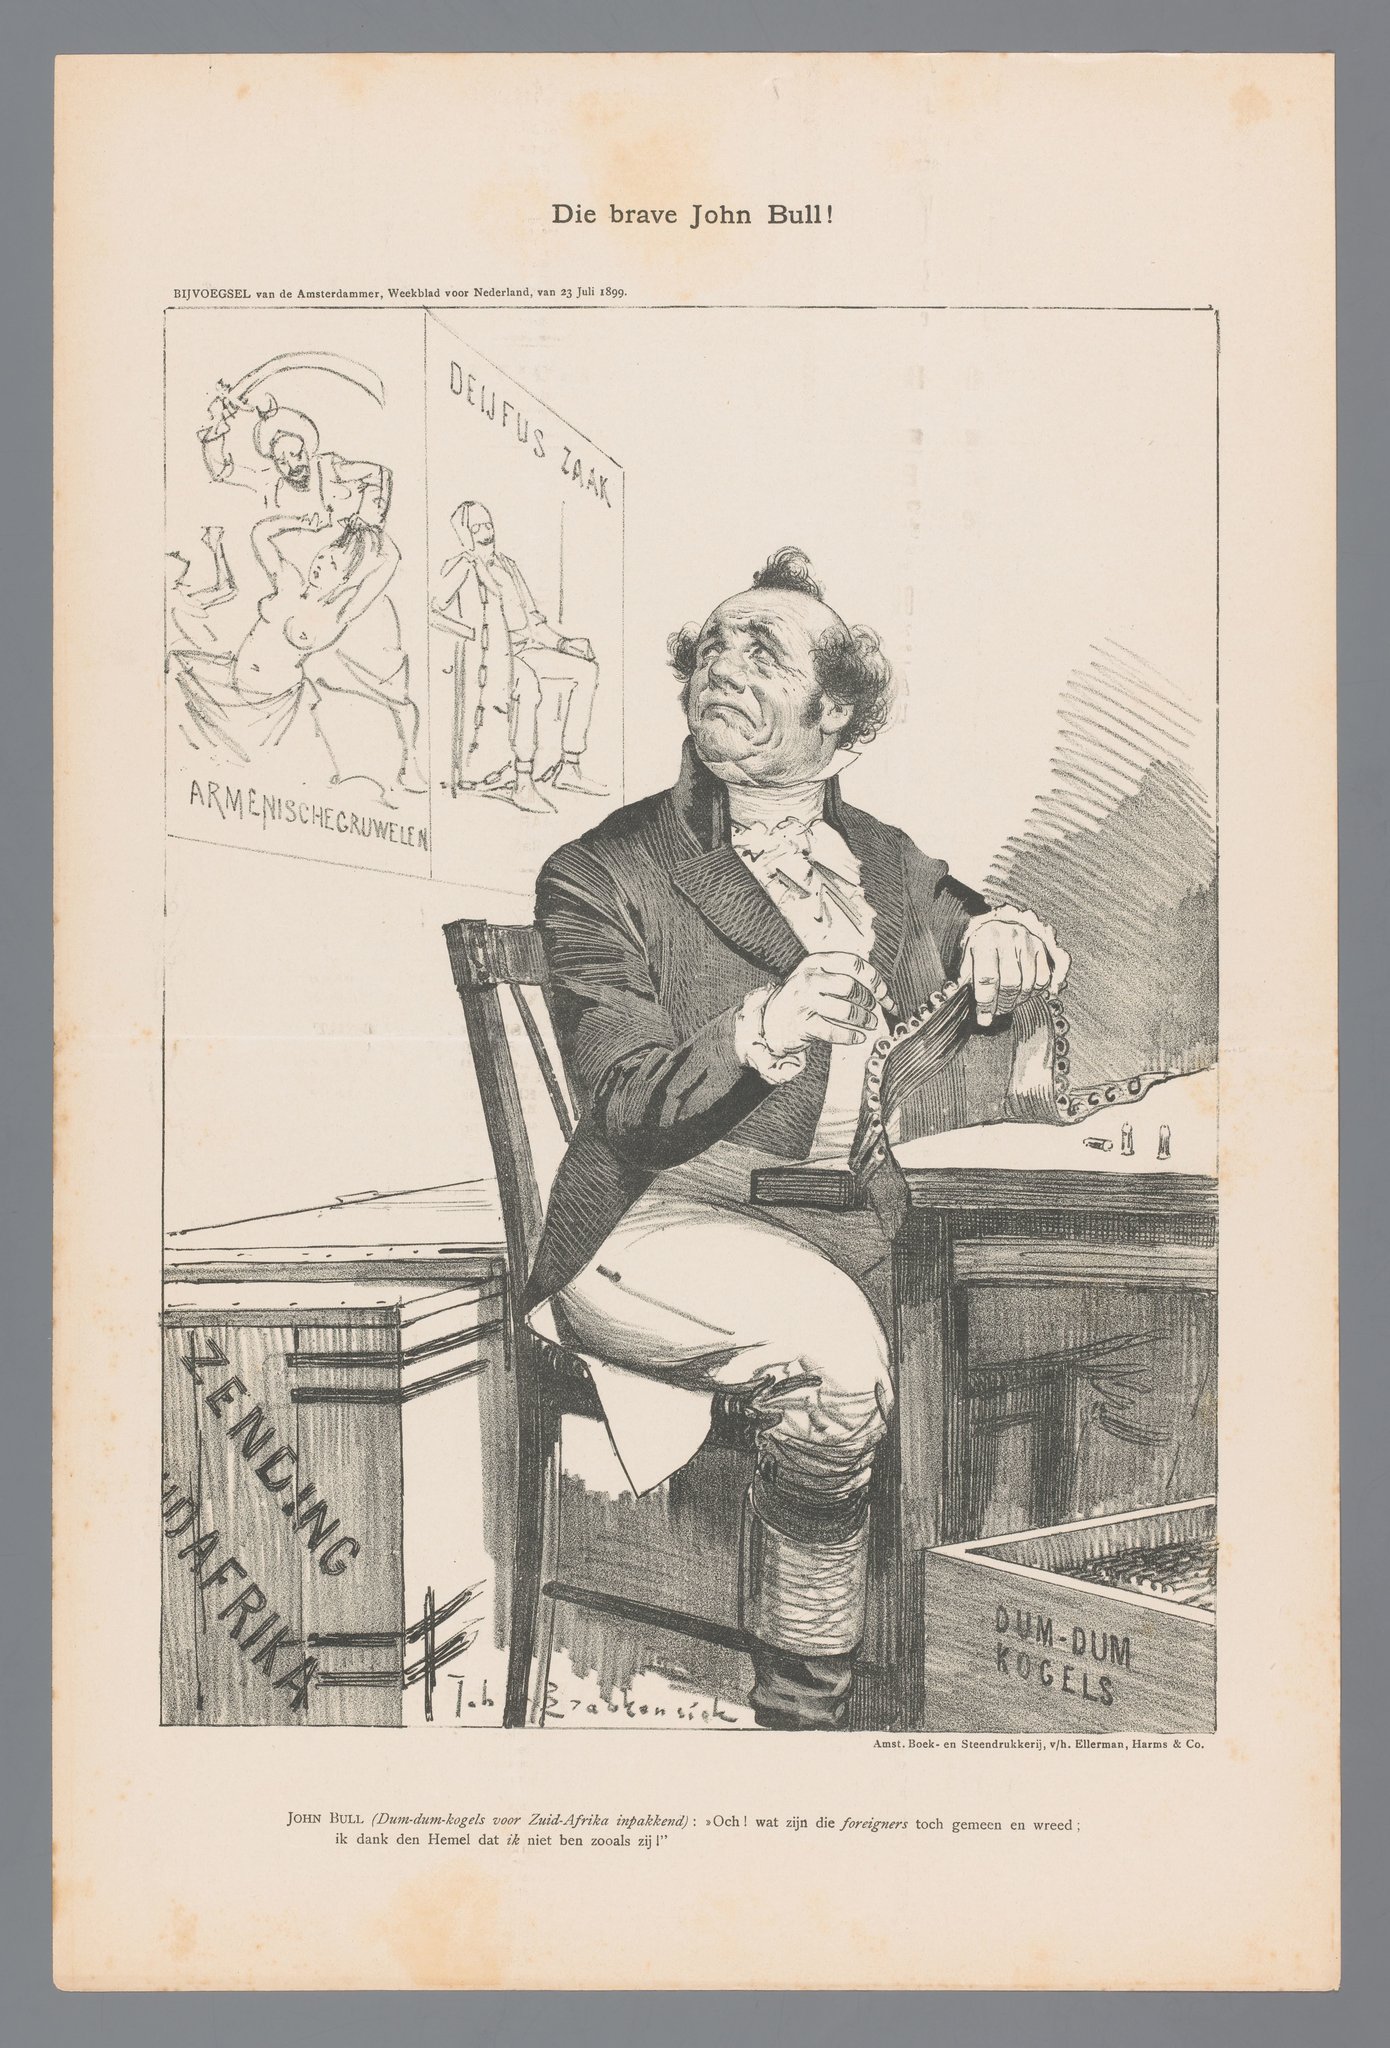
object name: cartoon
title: Die brave John Bull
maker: johan braakensiek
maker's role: draughtsman, print maker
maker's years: 1858-1940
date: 1899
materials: paper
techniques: lithograph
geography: amsterdam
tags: ammunition, personifications of countries, nations, states, districts, etc., political caricatures and satires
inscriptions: date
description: Prent uit het bijvoegsel van: De Amsterdammer. Weekblad voor Nederland, 23 juli 1899.